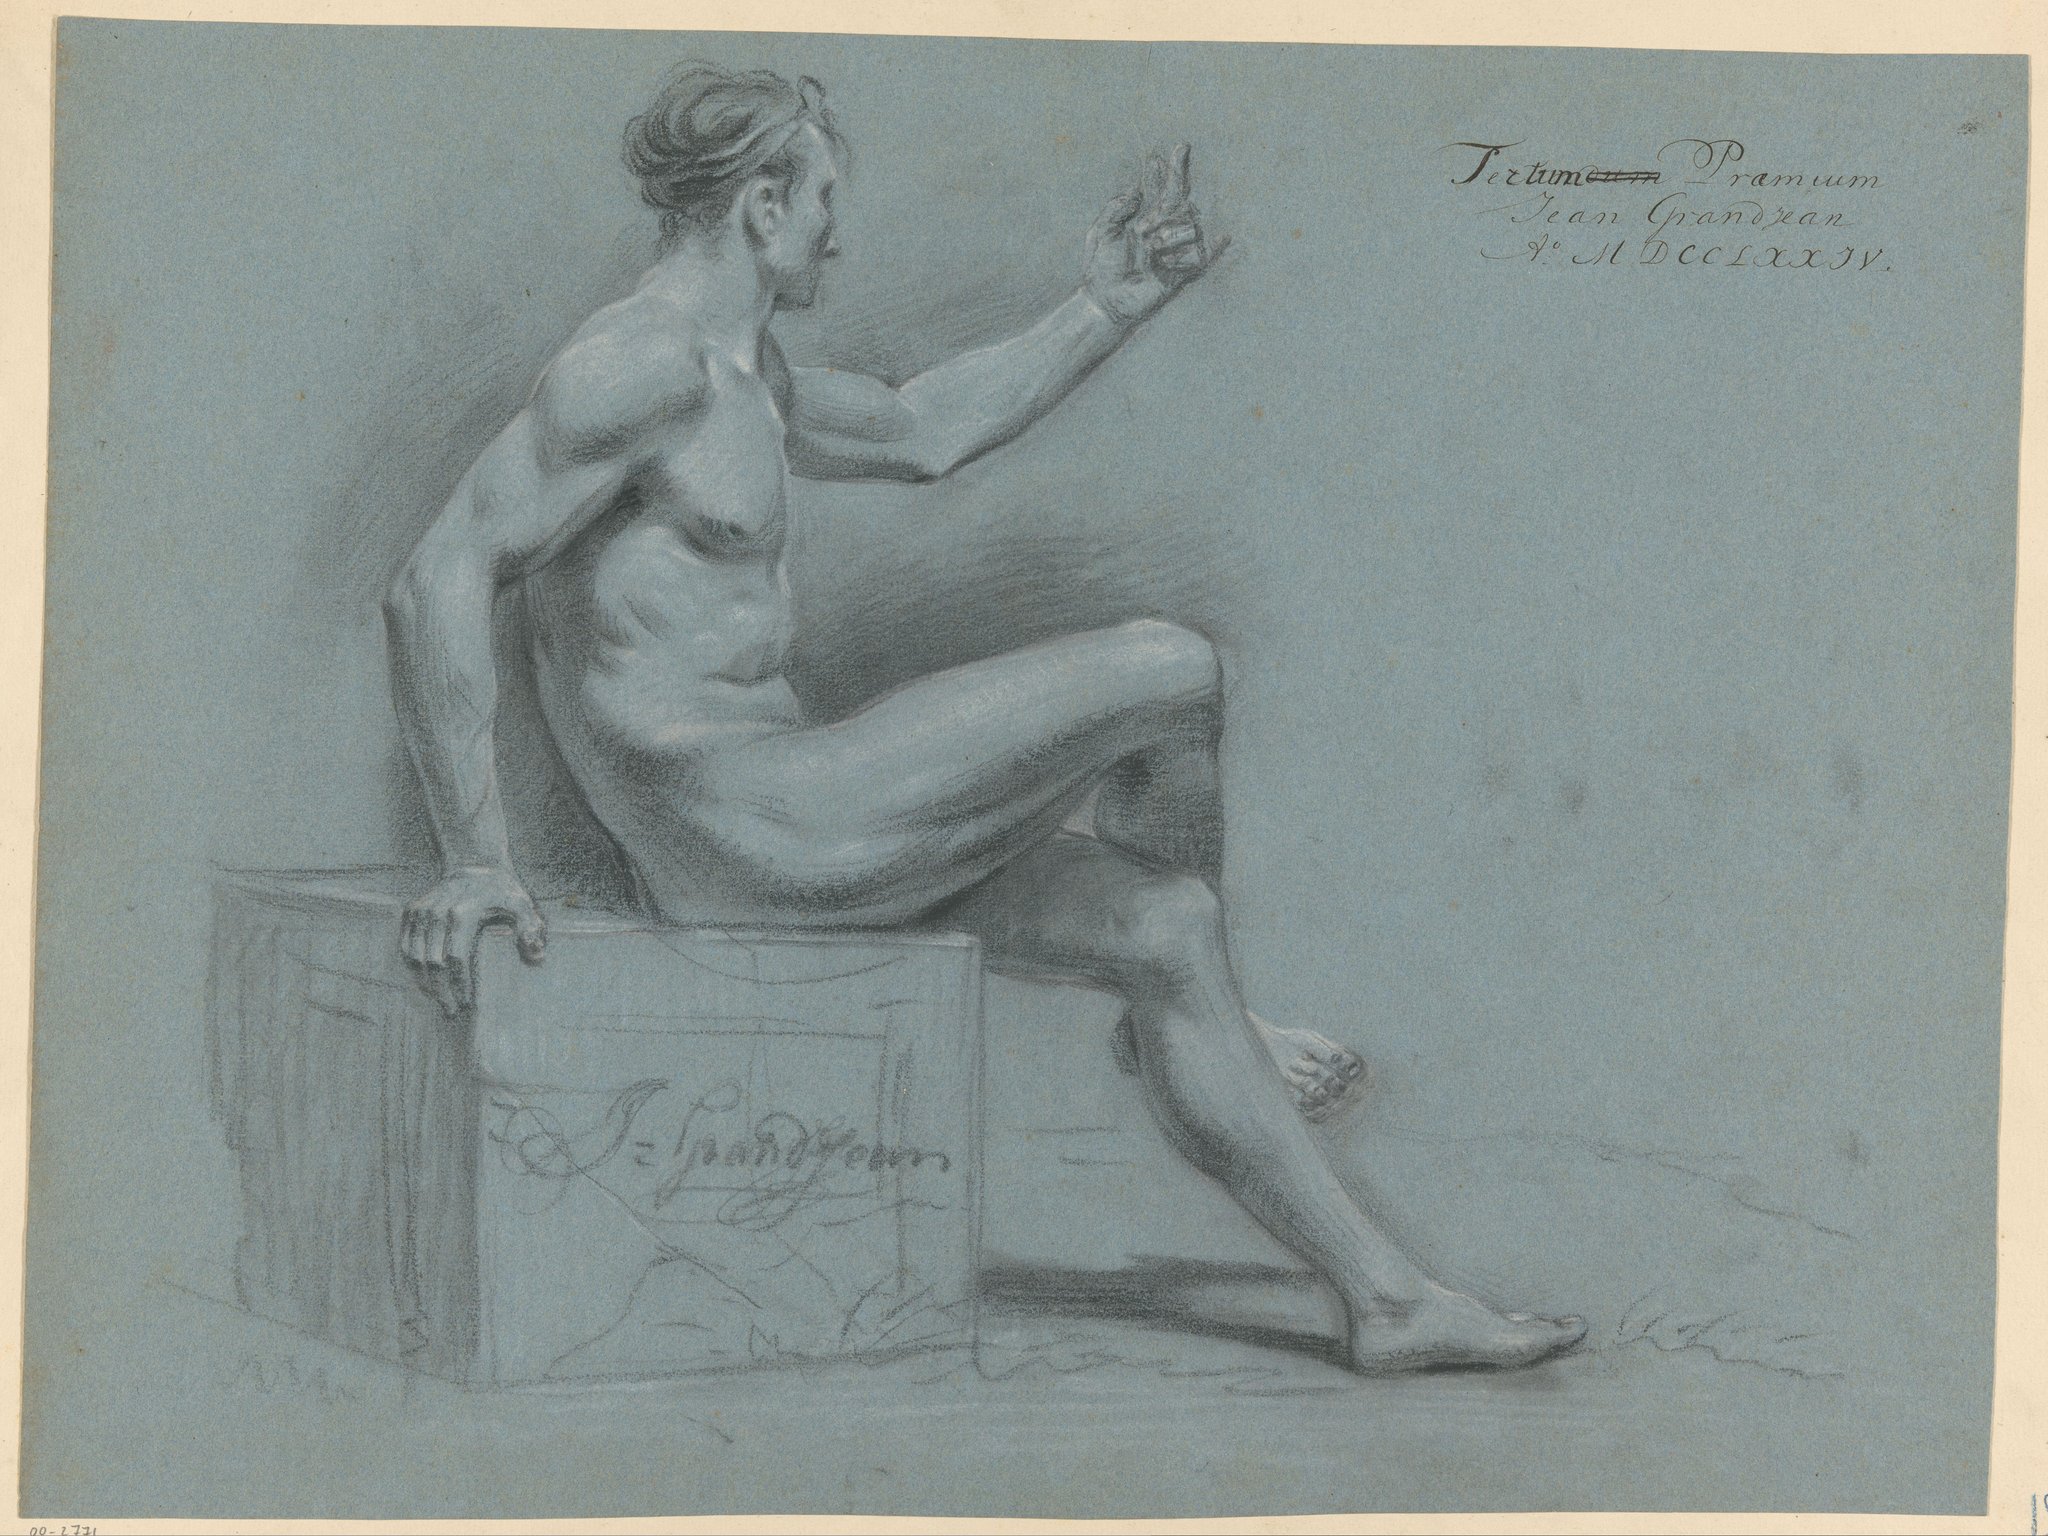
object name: drawing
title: Zittend mannelijk naakt, van opzij gezien (3e prijs 1774)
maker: jean grandjean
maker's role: draughtsman, print maker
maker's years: 1752-1781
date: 1774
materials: chalk, paper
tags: sitting figure (+ nude human being)